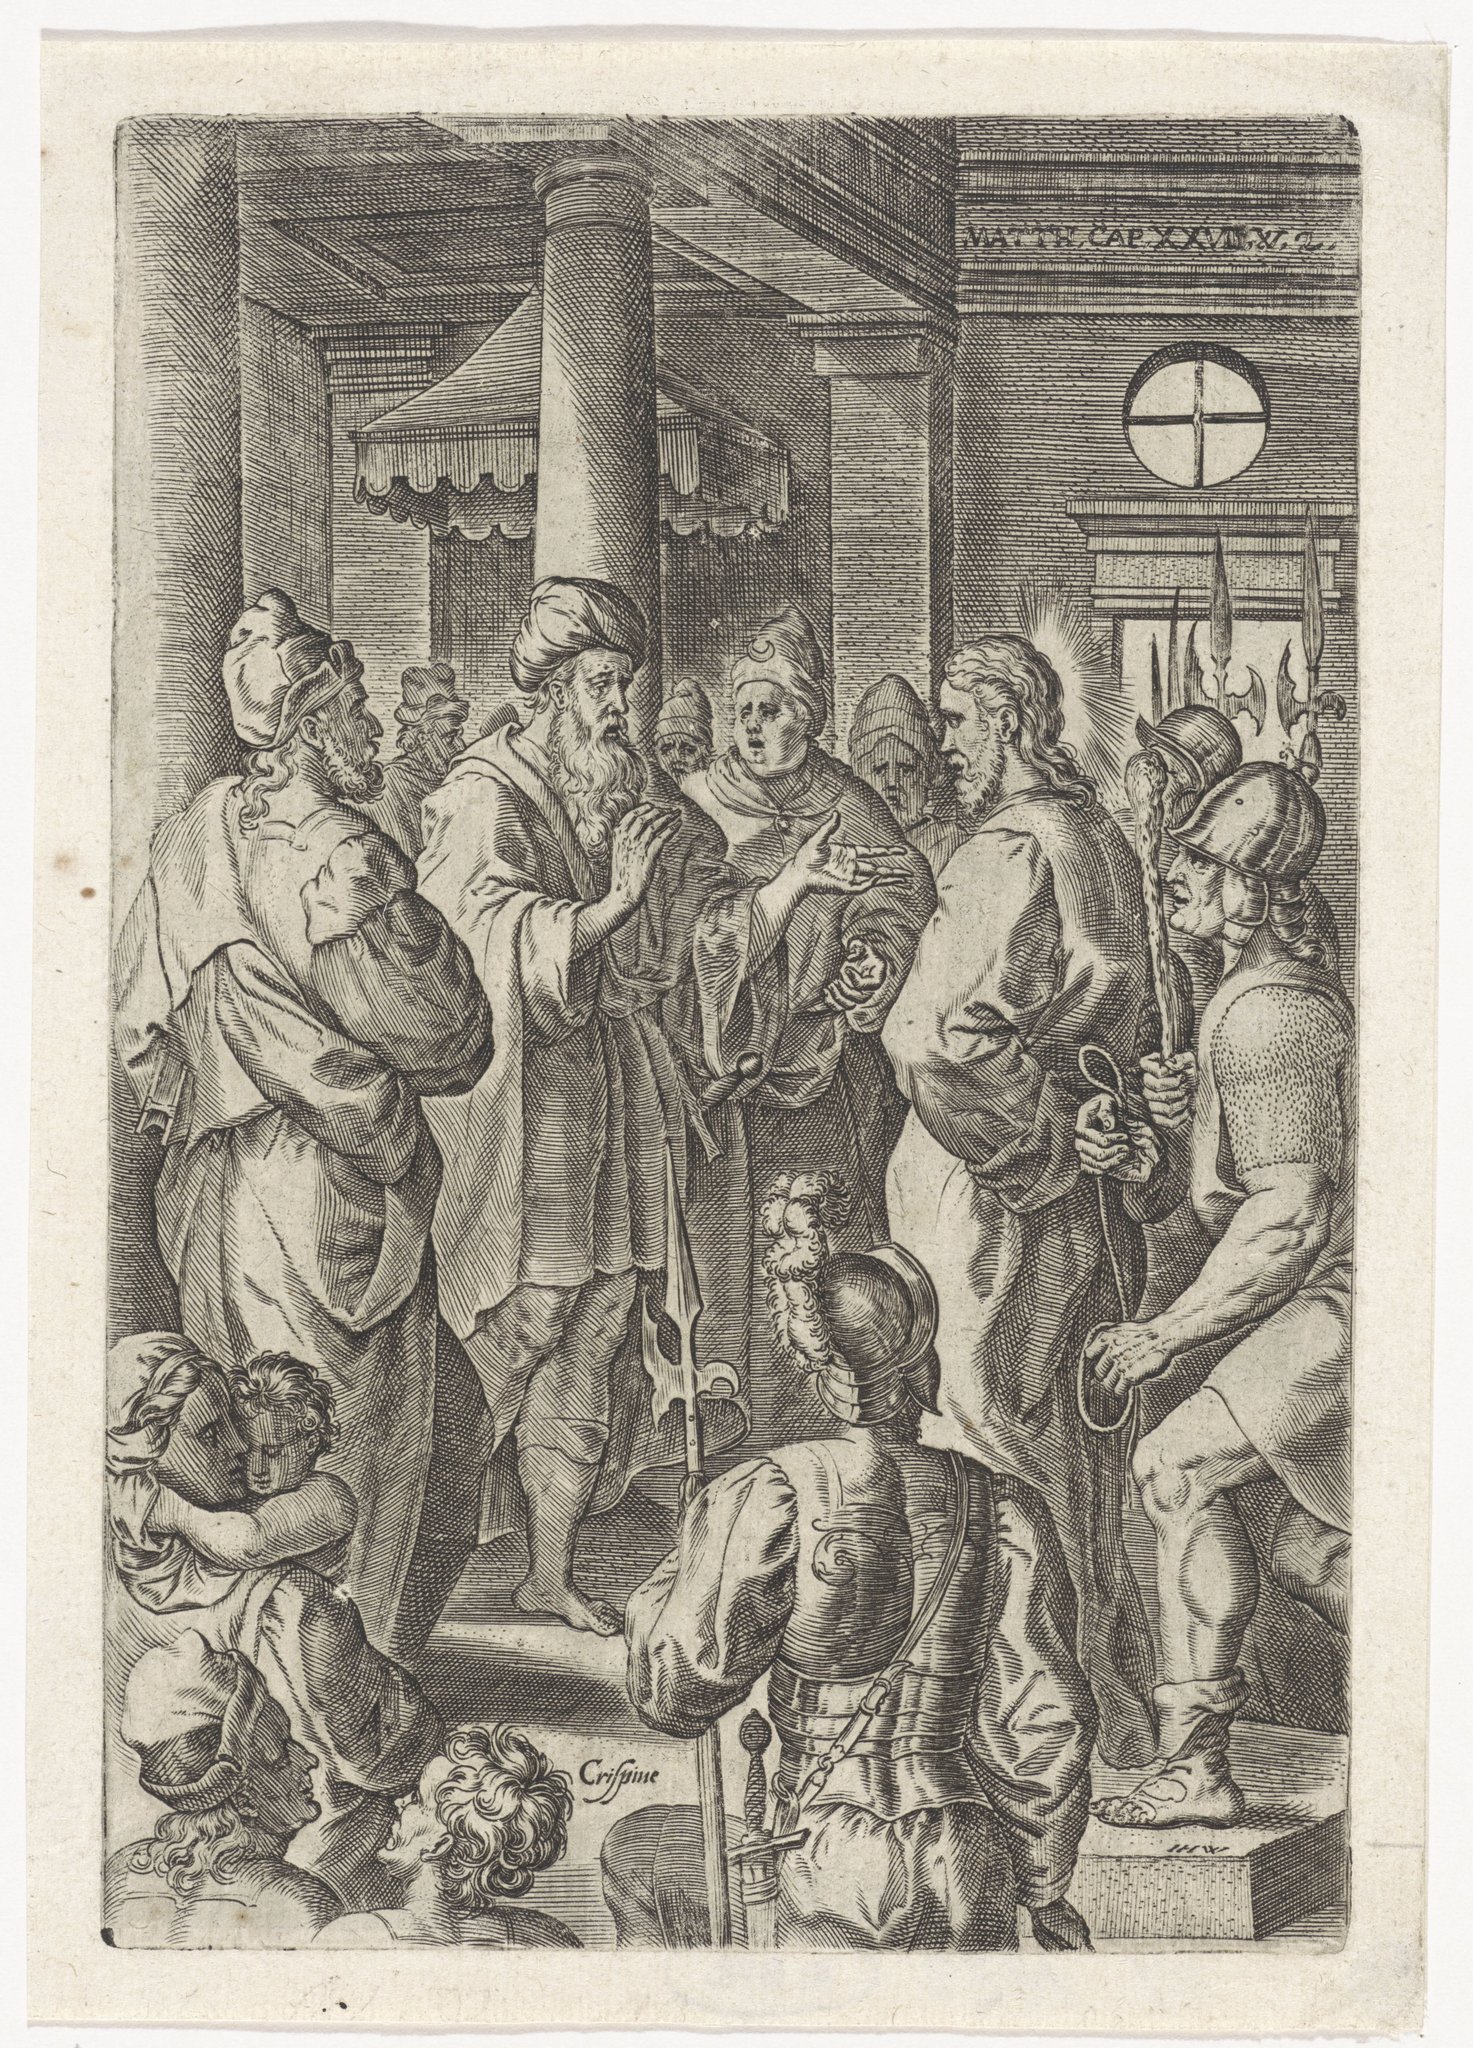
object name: print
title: Christus voor Pilatus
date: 1576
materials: paper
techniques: engraving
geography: antwerp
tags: christ before pontius pilate (matthew 27:11-26; mark 15:2-15; luke 23:2-7, 23:13-25; john 18:28 - 19:16)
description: Christus wordt door gewapende soldaten voor Pilatus gebracht. Pilatus vraagt hem of hij de koning van de joden is. Omstanders kijken toe. Rechtsboven gemarkeerd: "Matth.Cap.XXVII.VS.2.".